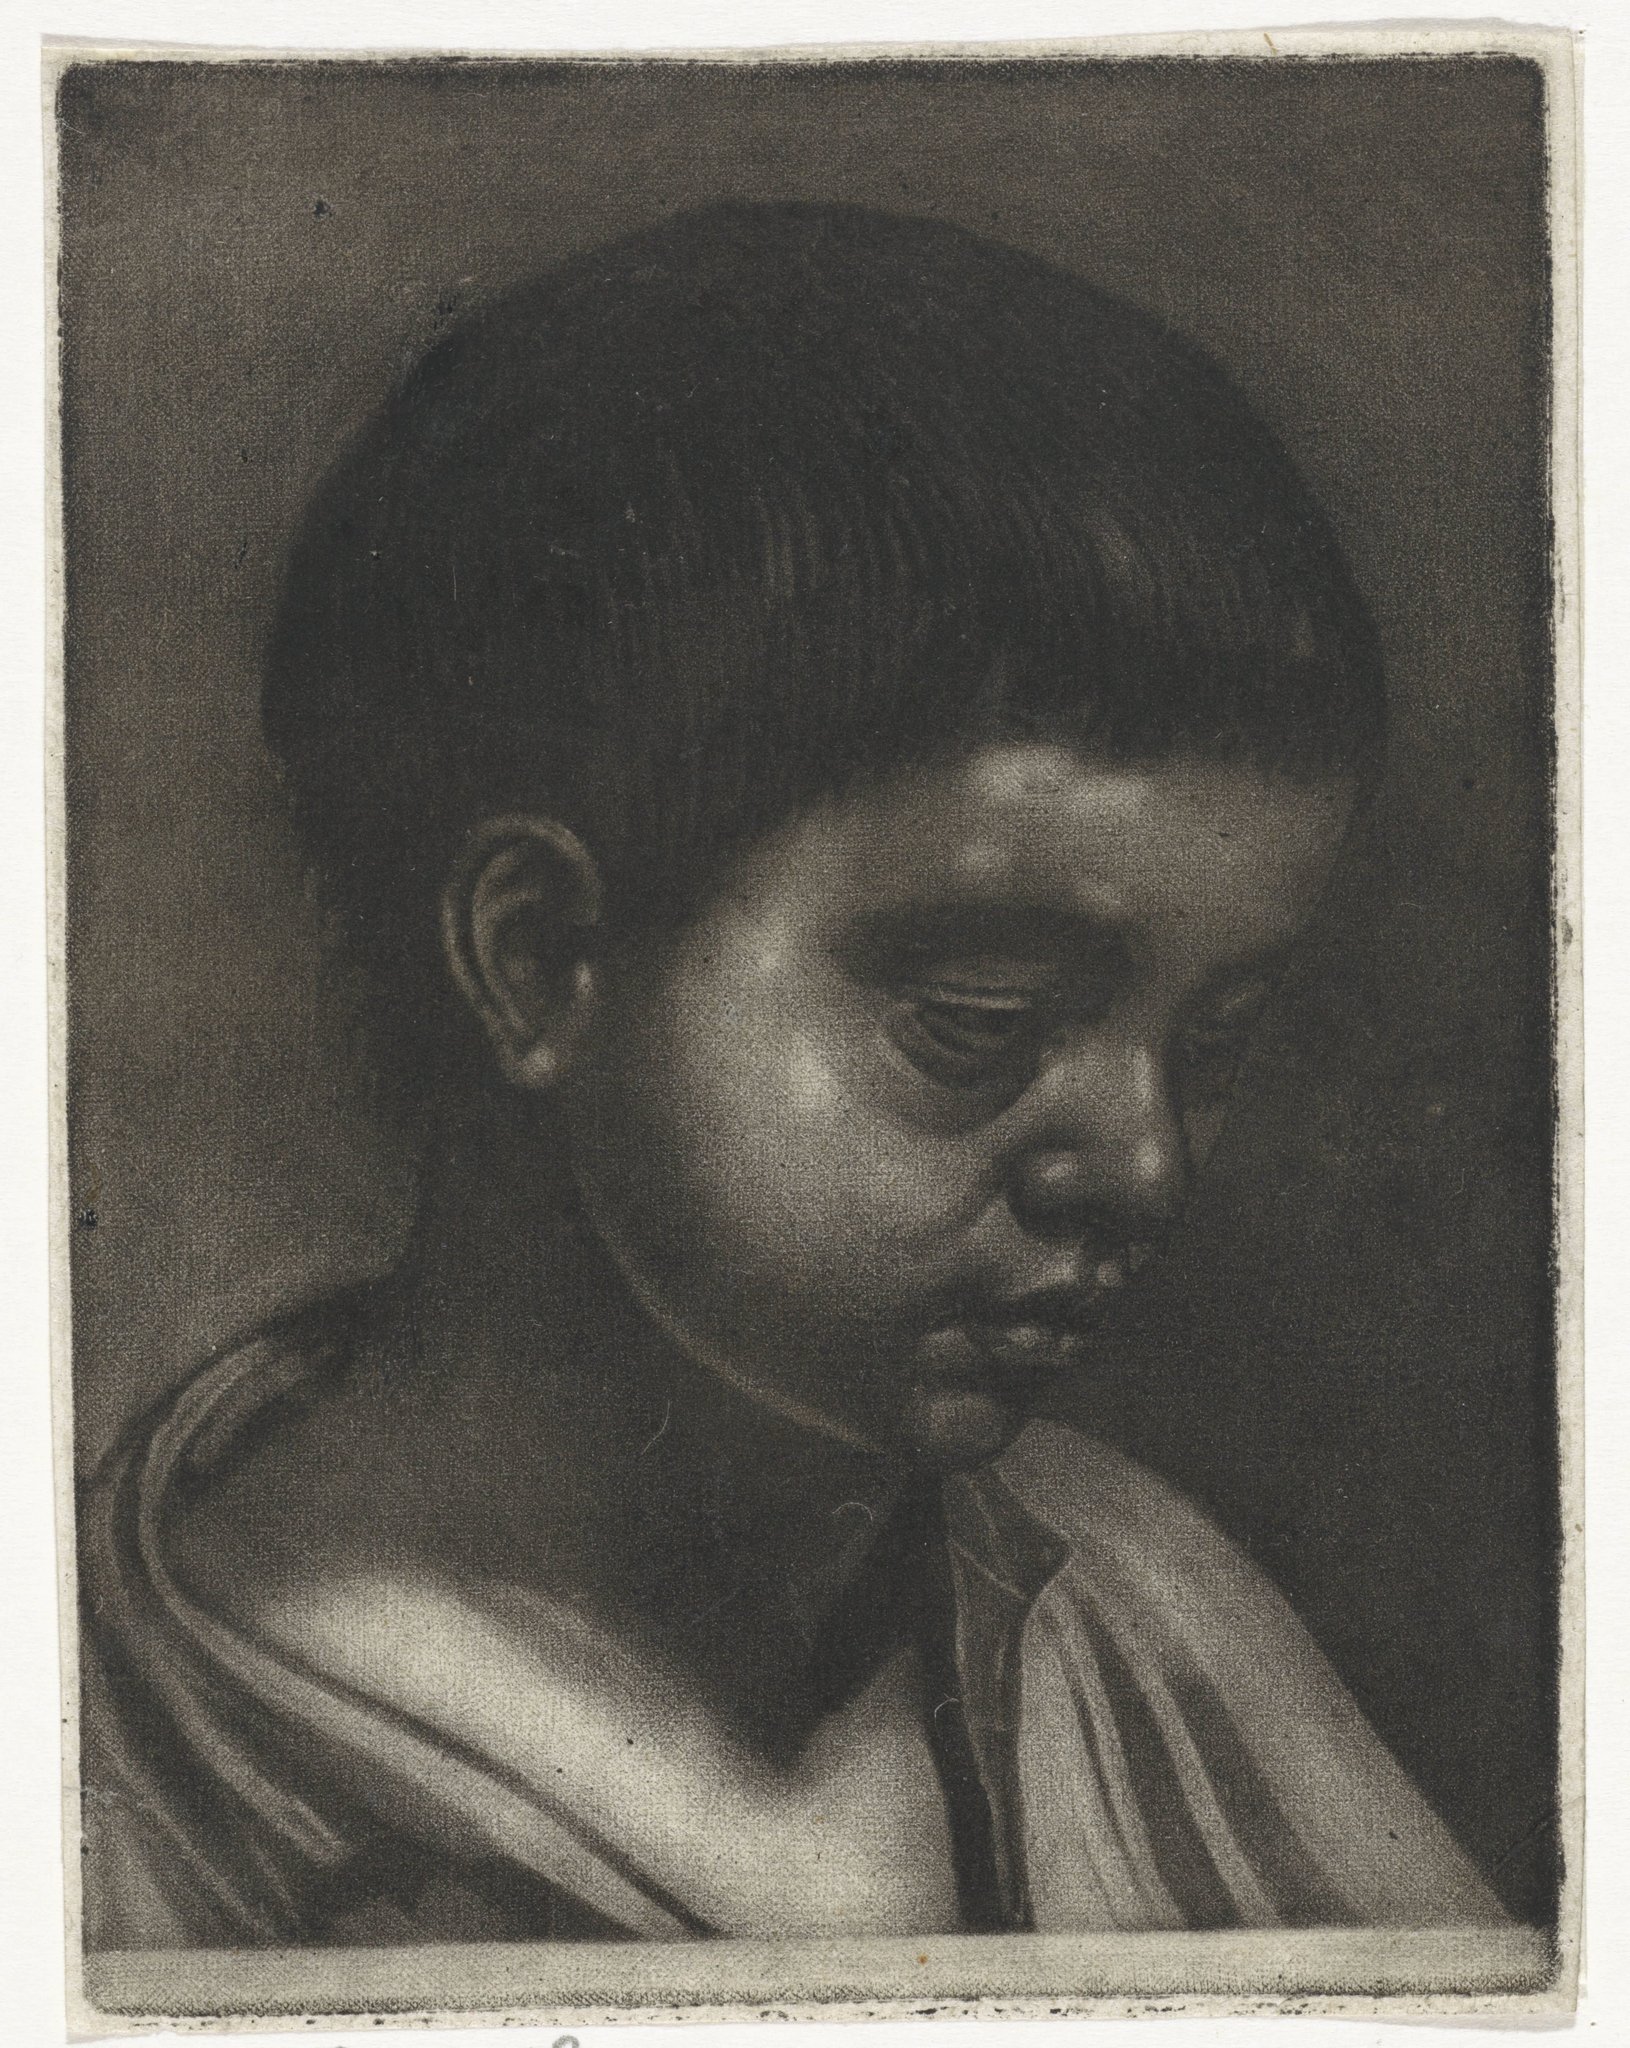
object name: print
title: Hoofd van een jongen, naar rechts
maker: Anonymous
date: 1658-1727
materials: paper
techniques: mezzotint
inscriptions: collector's mark: Lugt 2228